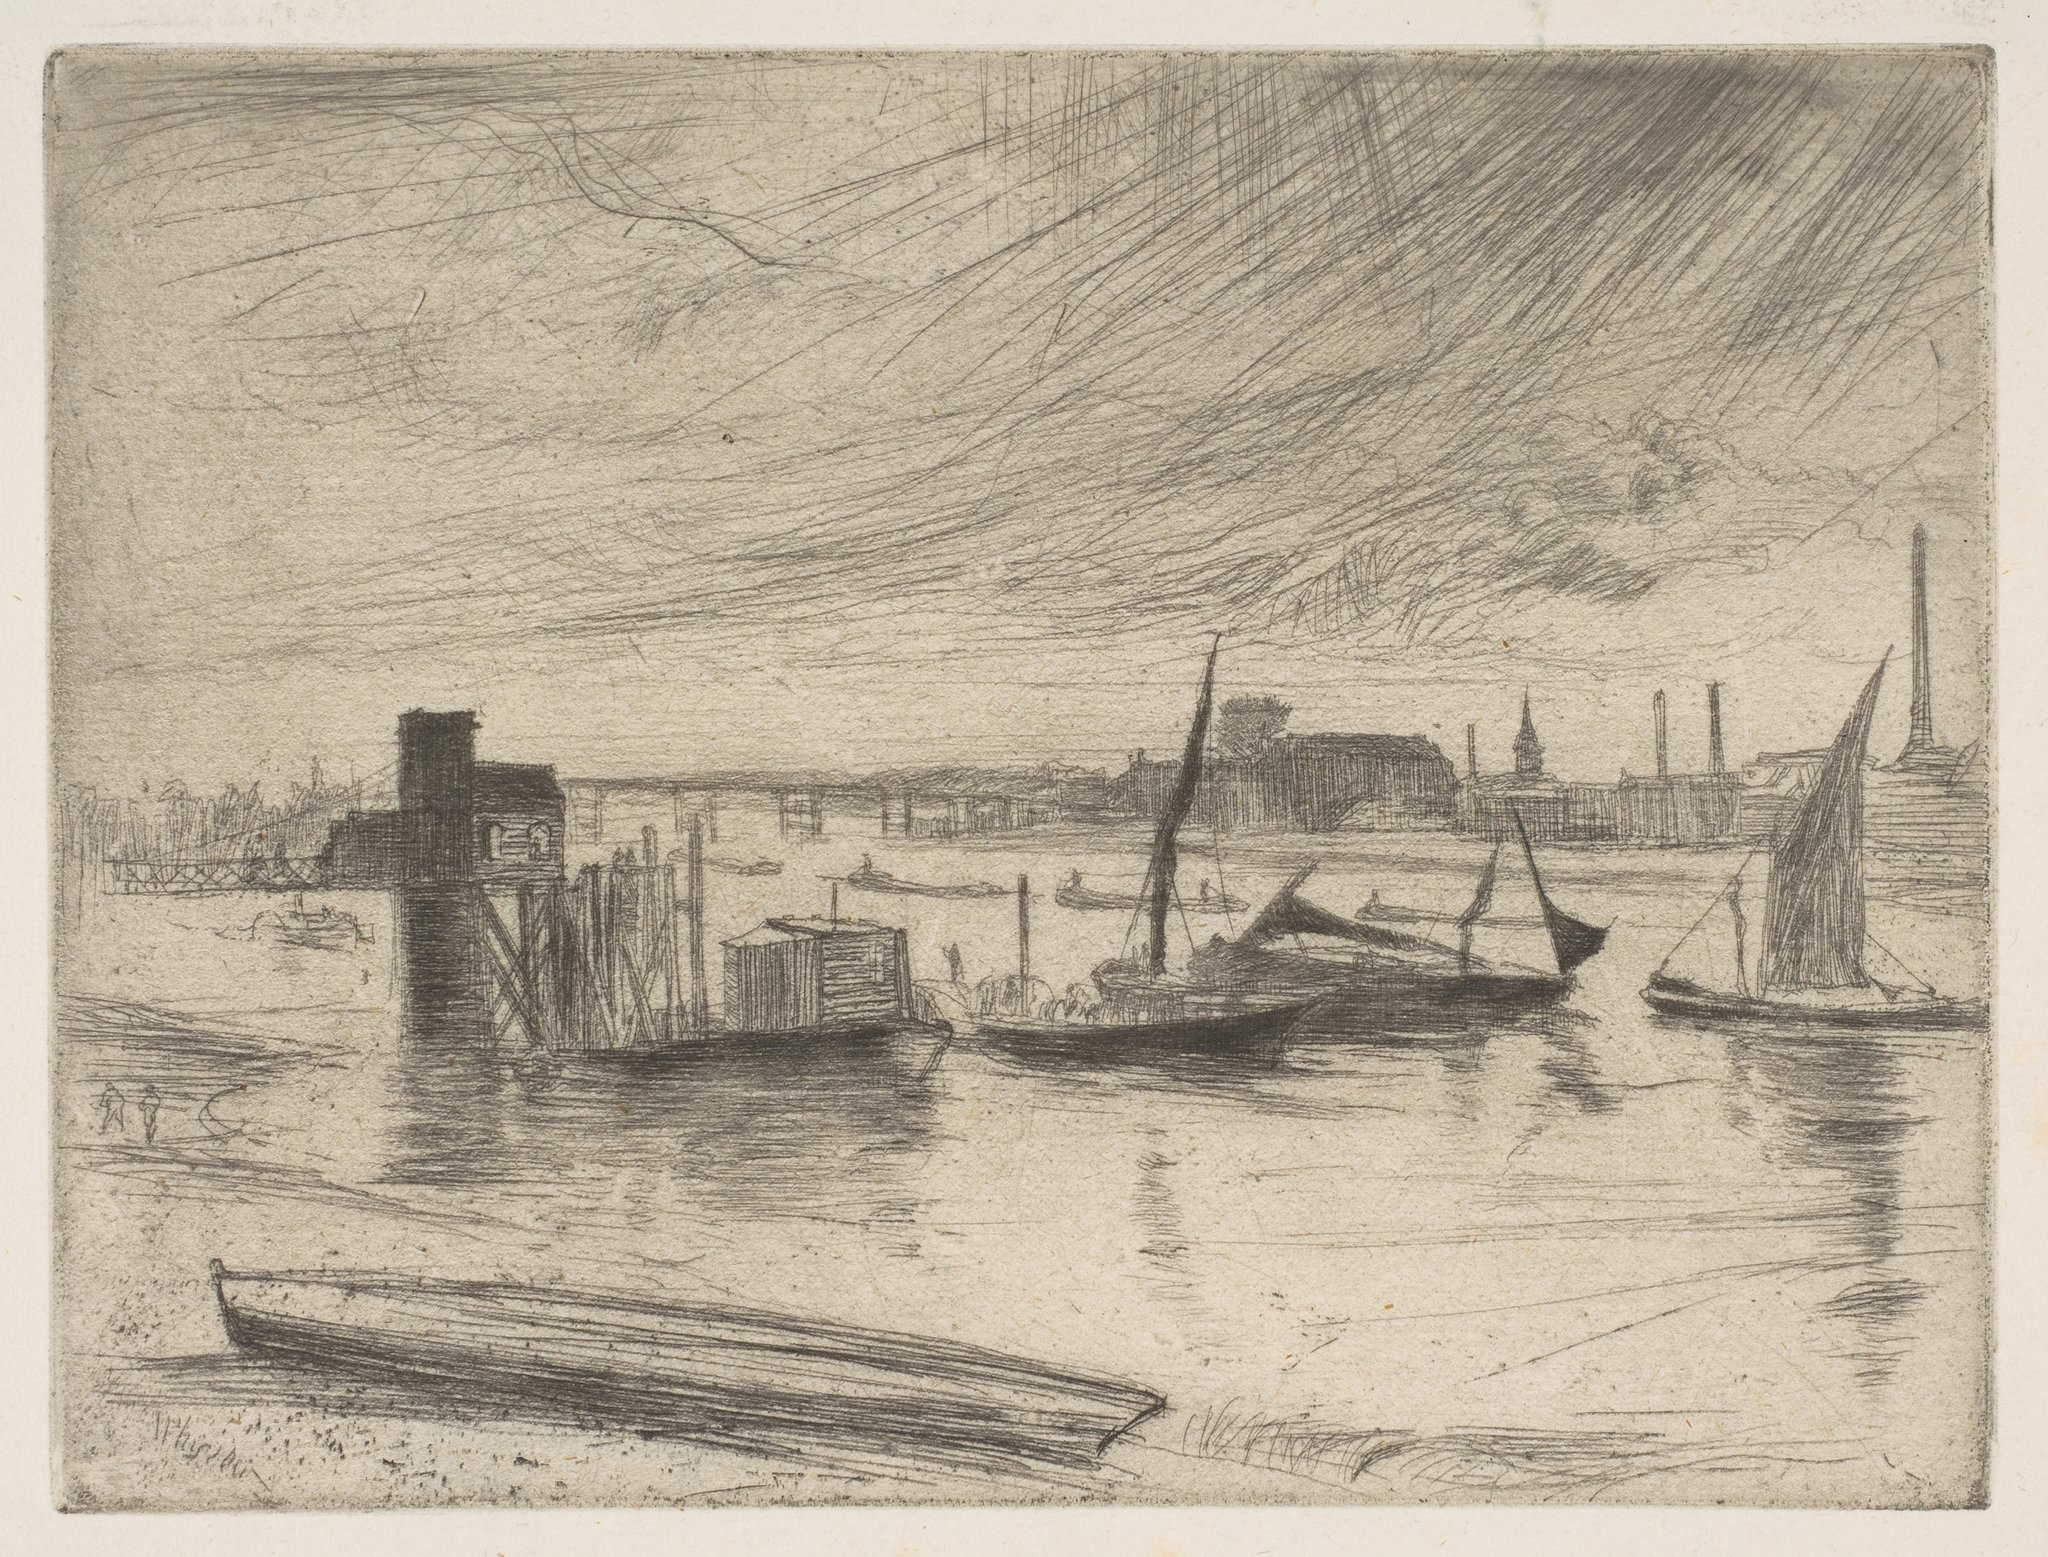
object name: print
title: Early Morning, Battersea (Battersea Dawn) (Cadogan Pier)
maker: james mcneill whistler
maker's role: artist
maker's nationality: american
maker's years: 1834-1903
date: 1861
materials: ink, paper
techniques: drypoint, etching, printing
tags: rivers,boats,piers